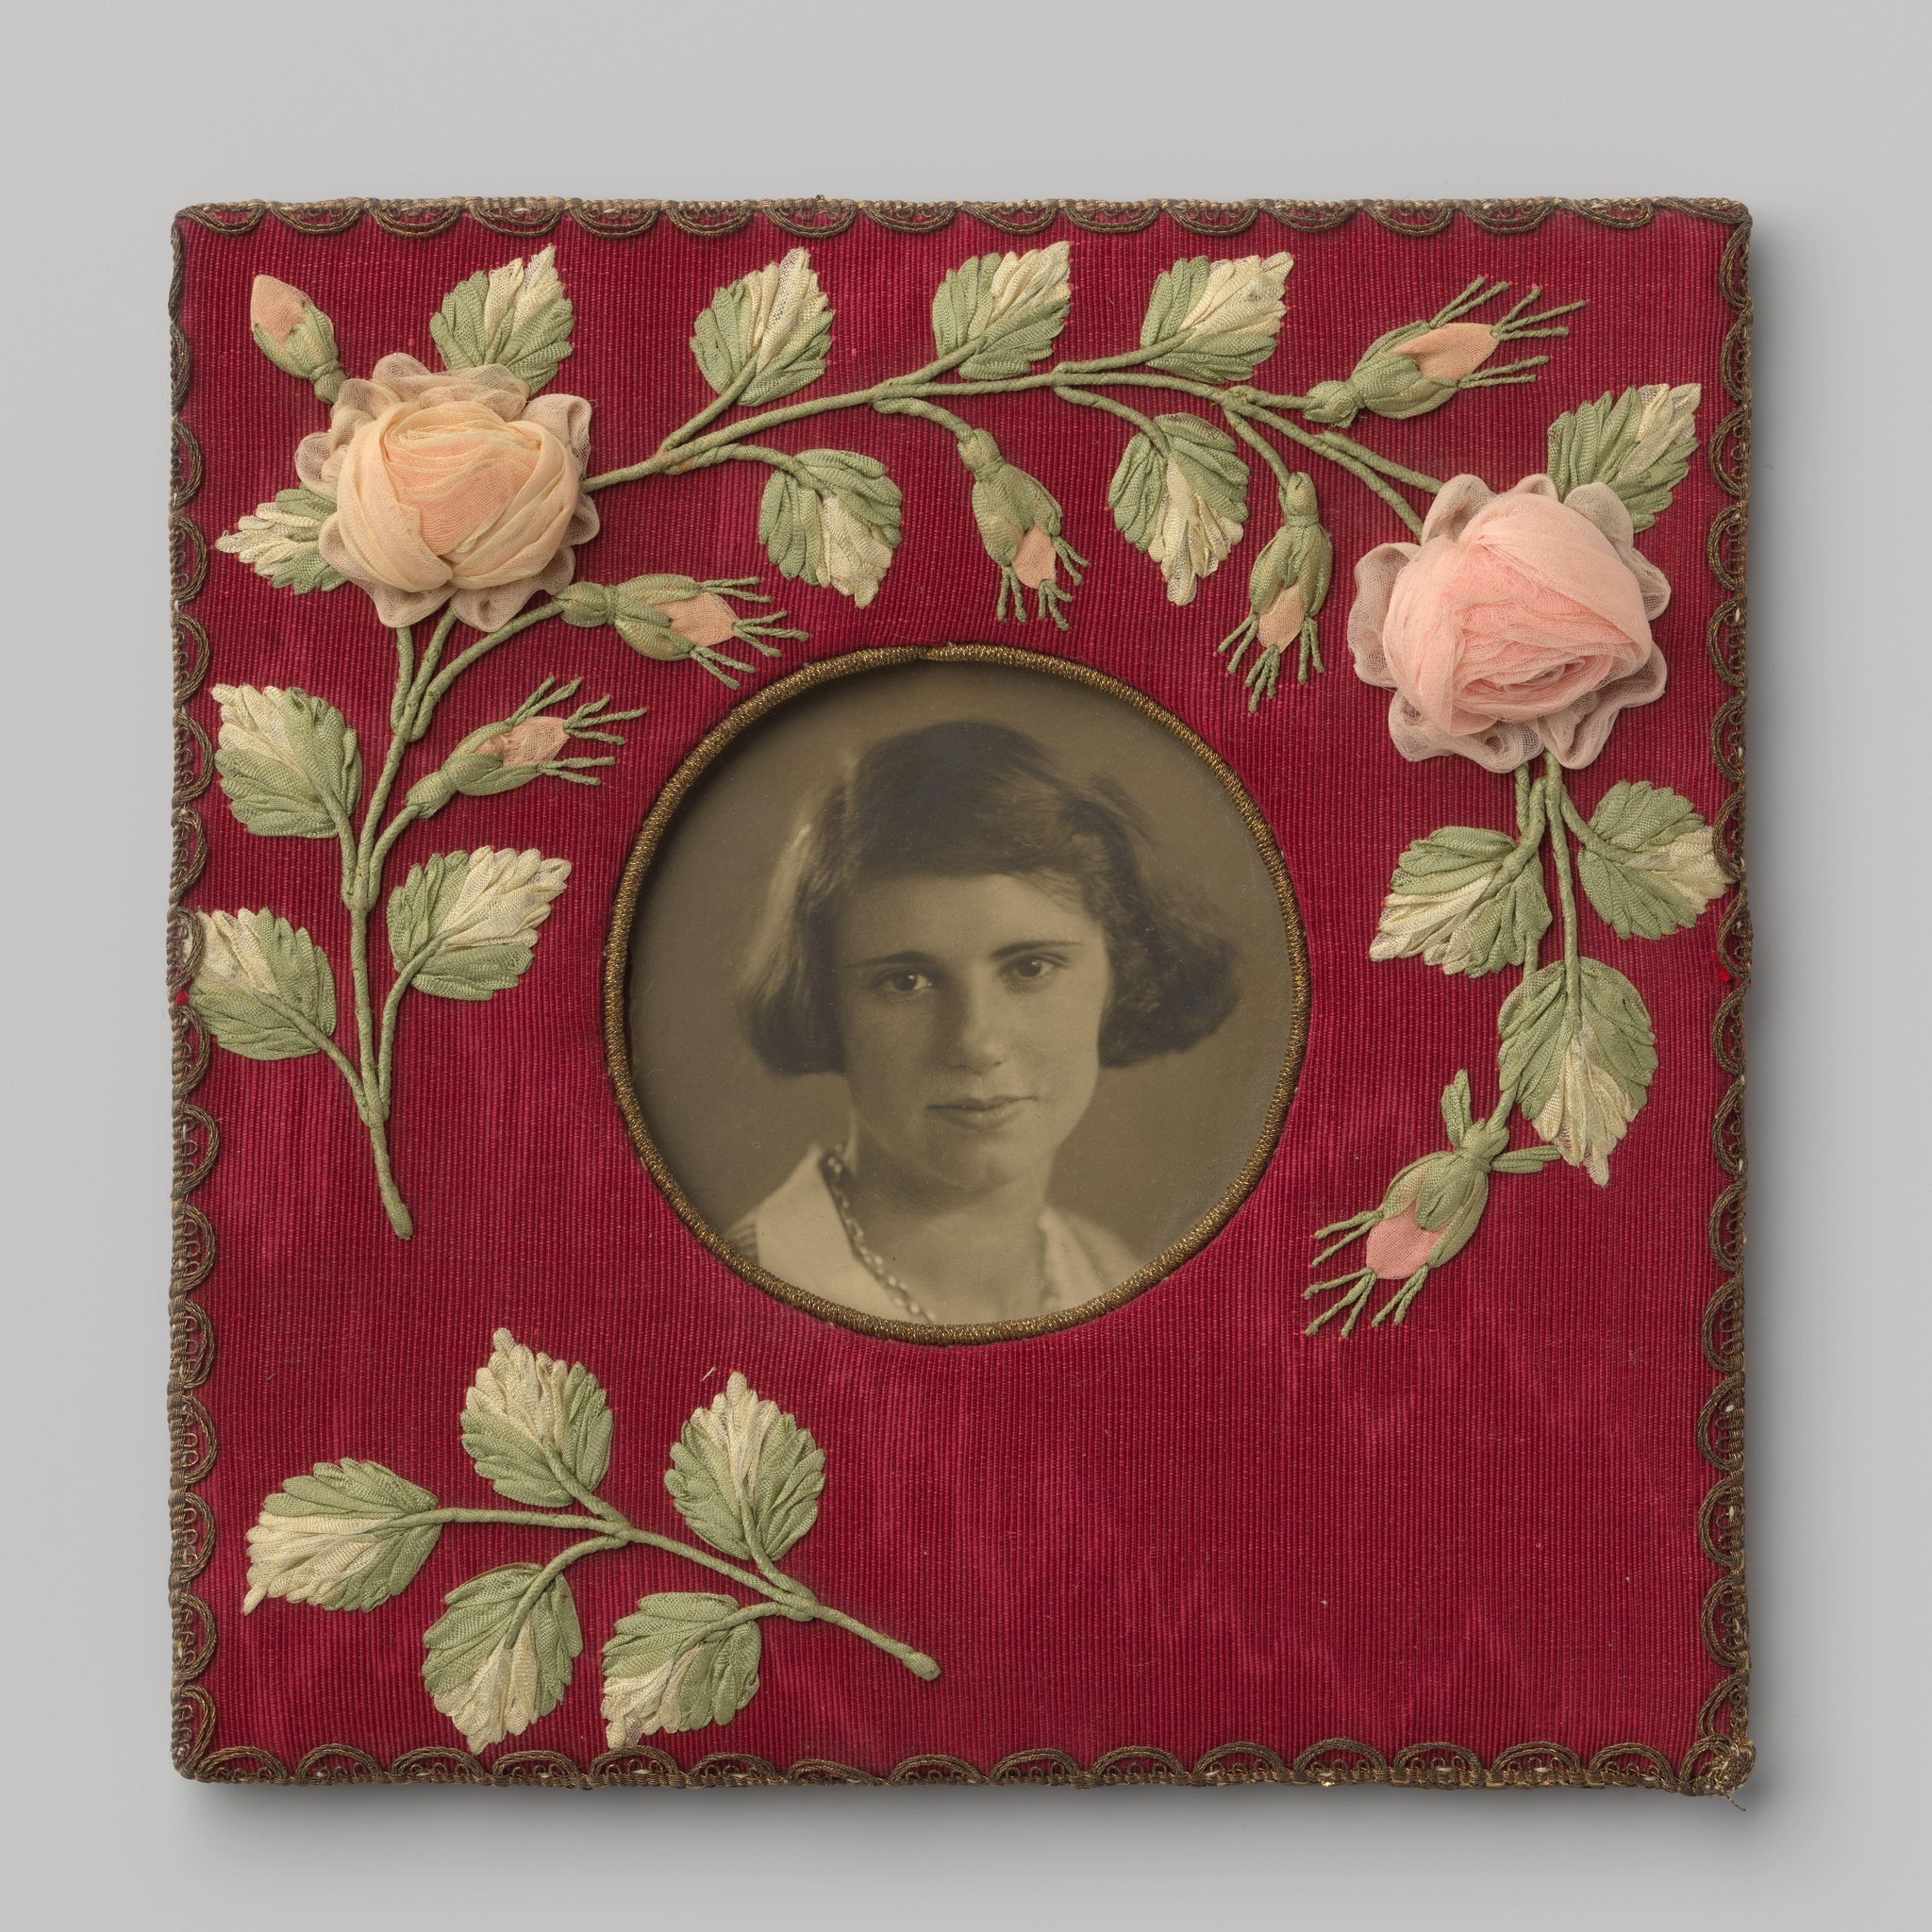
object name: photograph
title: Portret van een onbekende jonge vrouw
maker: Anonymous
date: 1880-1900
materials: paper, cardboard, glass, textile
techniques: gelatin silver print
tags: adolescent, young woman, maiden, anonymous historical person portrayed